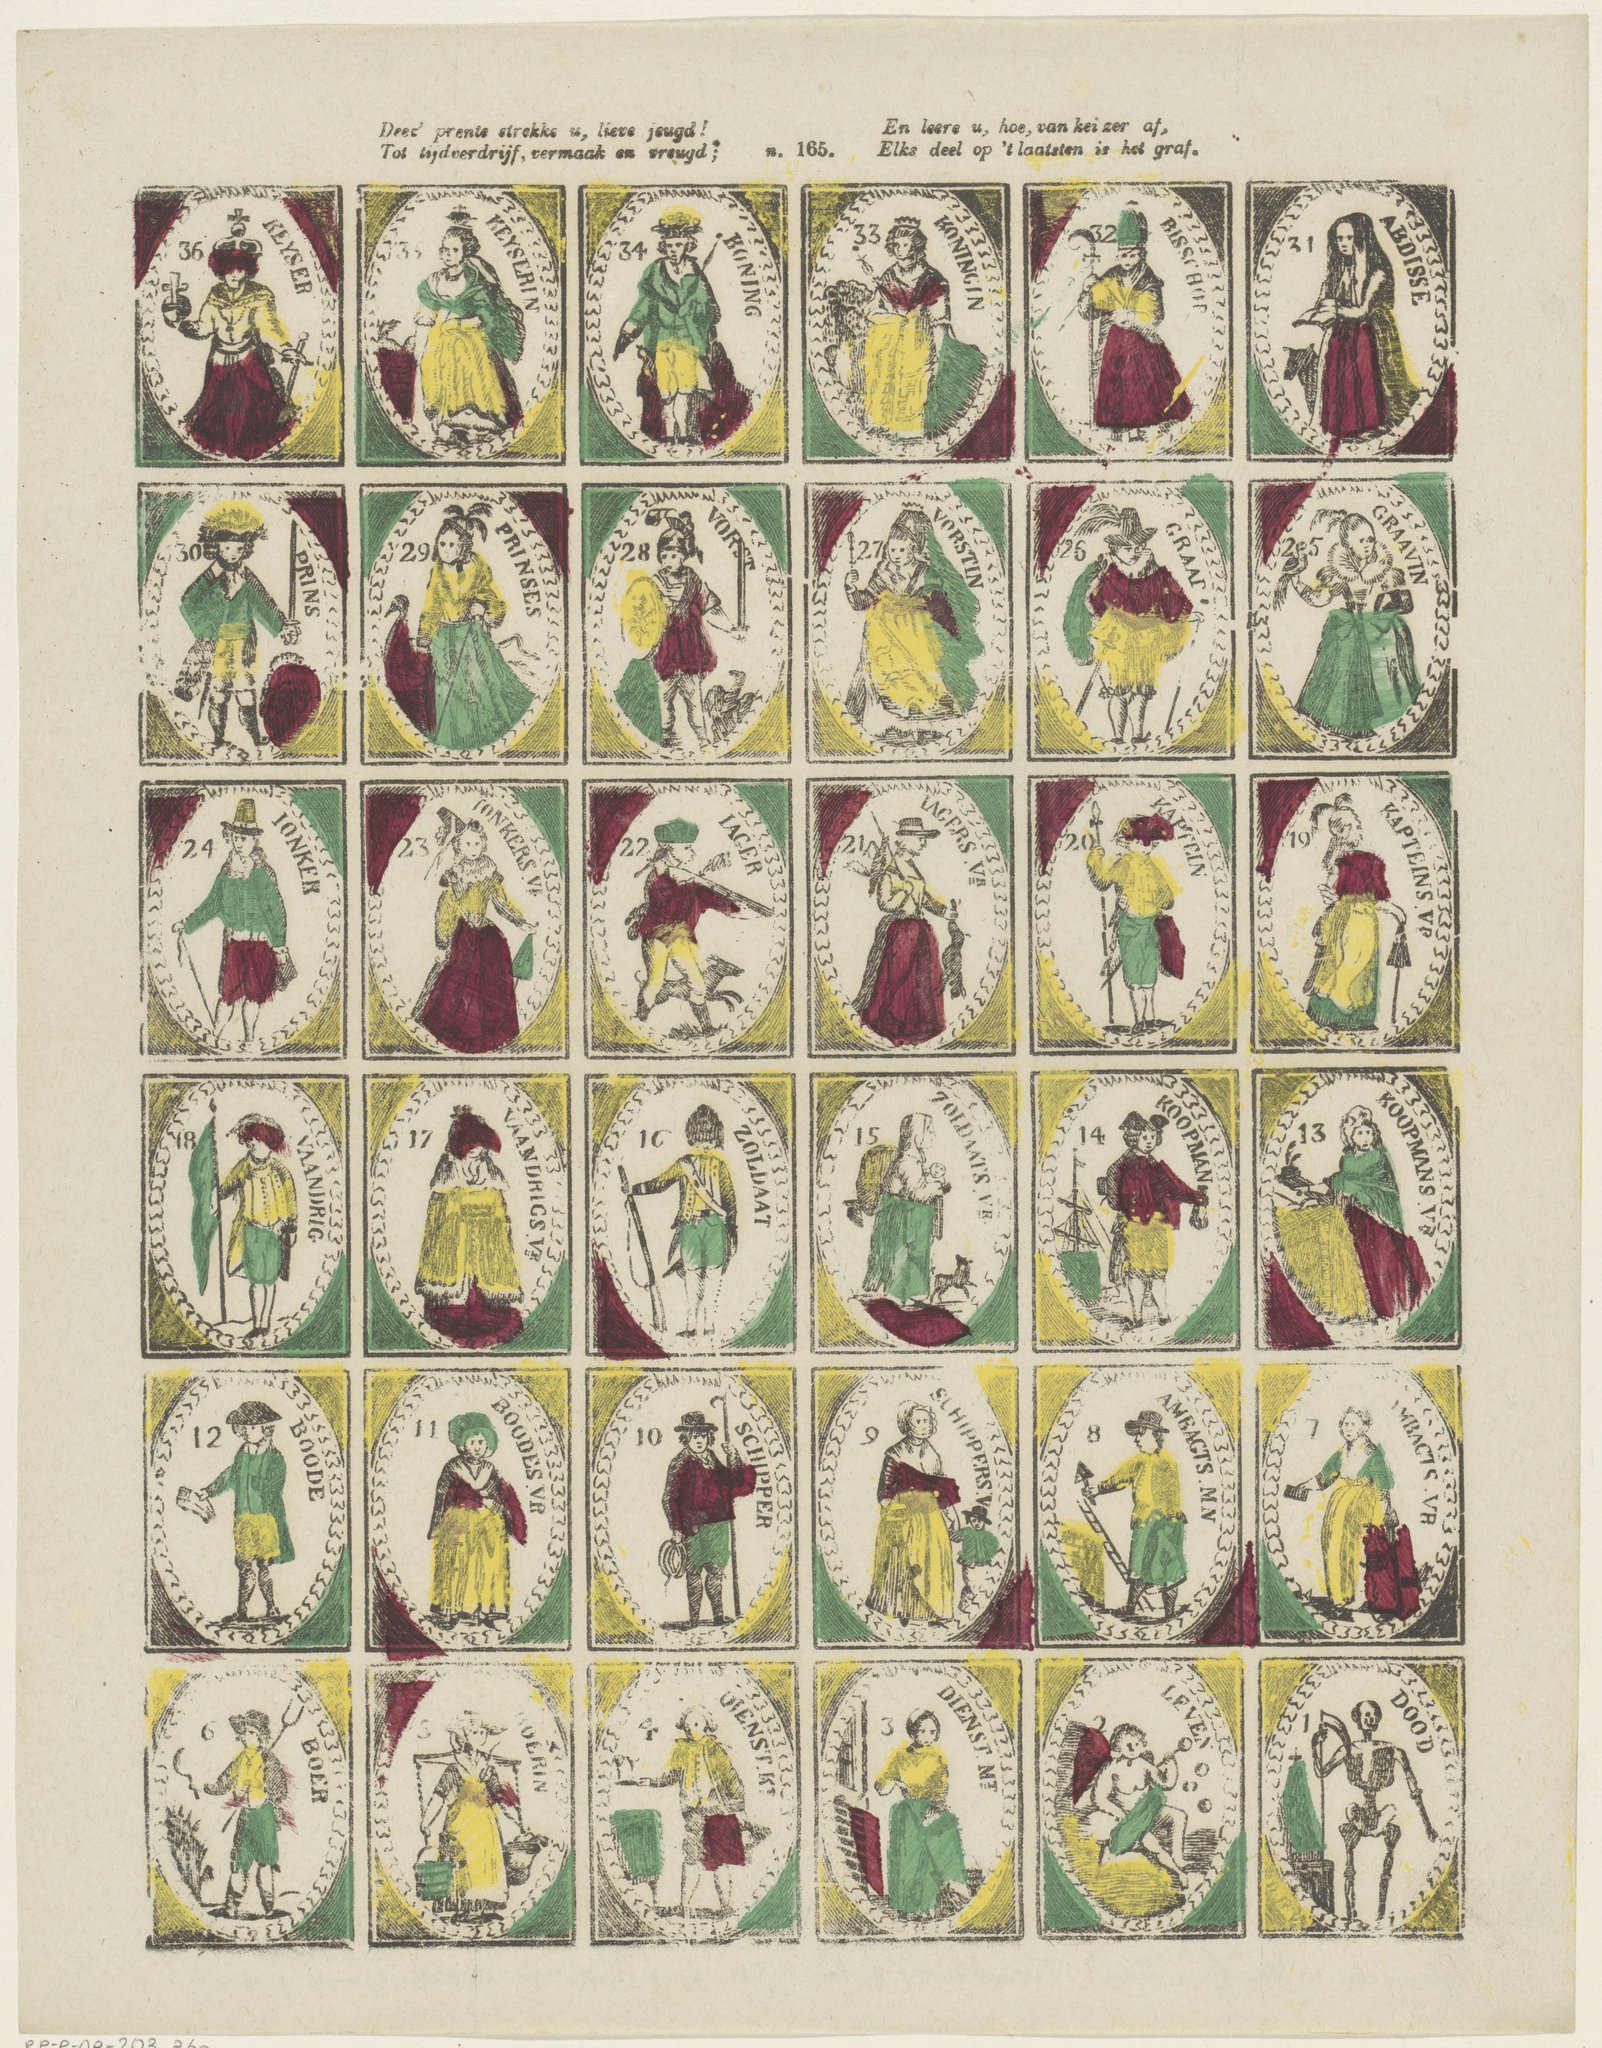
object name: popular print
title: Floskaartjes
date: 1833-1900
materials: paper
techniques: colour, letterpress printing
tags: symbols and personifications of death, social position, playing-cards, nobility and patriciate; chivalry, knighthood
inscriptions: collector's mark: Lugt 2760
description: Blad met 36 speelkaarten (floskaartjes) met voorstellingen van verschillende figuren. De afbeeldingen vormen achttien paren, aflopend genummerd van bovenaan links nummer 36 tot onderaan rechts nummer 1. Op de twee laagste nummers na tonen ze zeventien koppels, man en vrouw, met de man net één nummer hoger dan de vrouw, waarbij elk paar een beroep of een maatschappelijke positie voorstelt. Genummerd midden boven: n. 165.